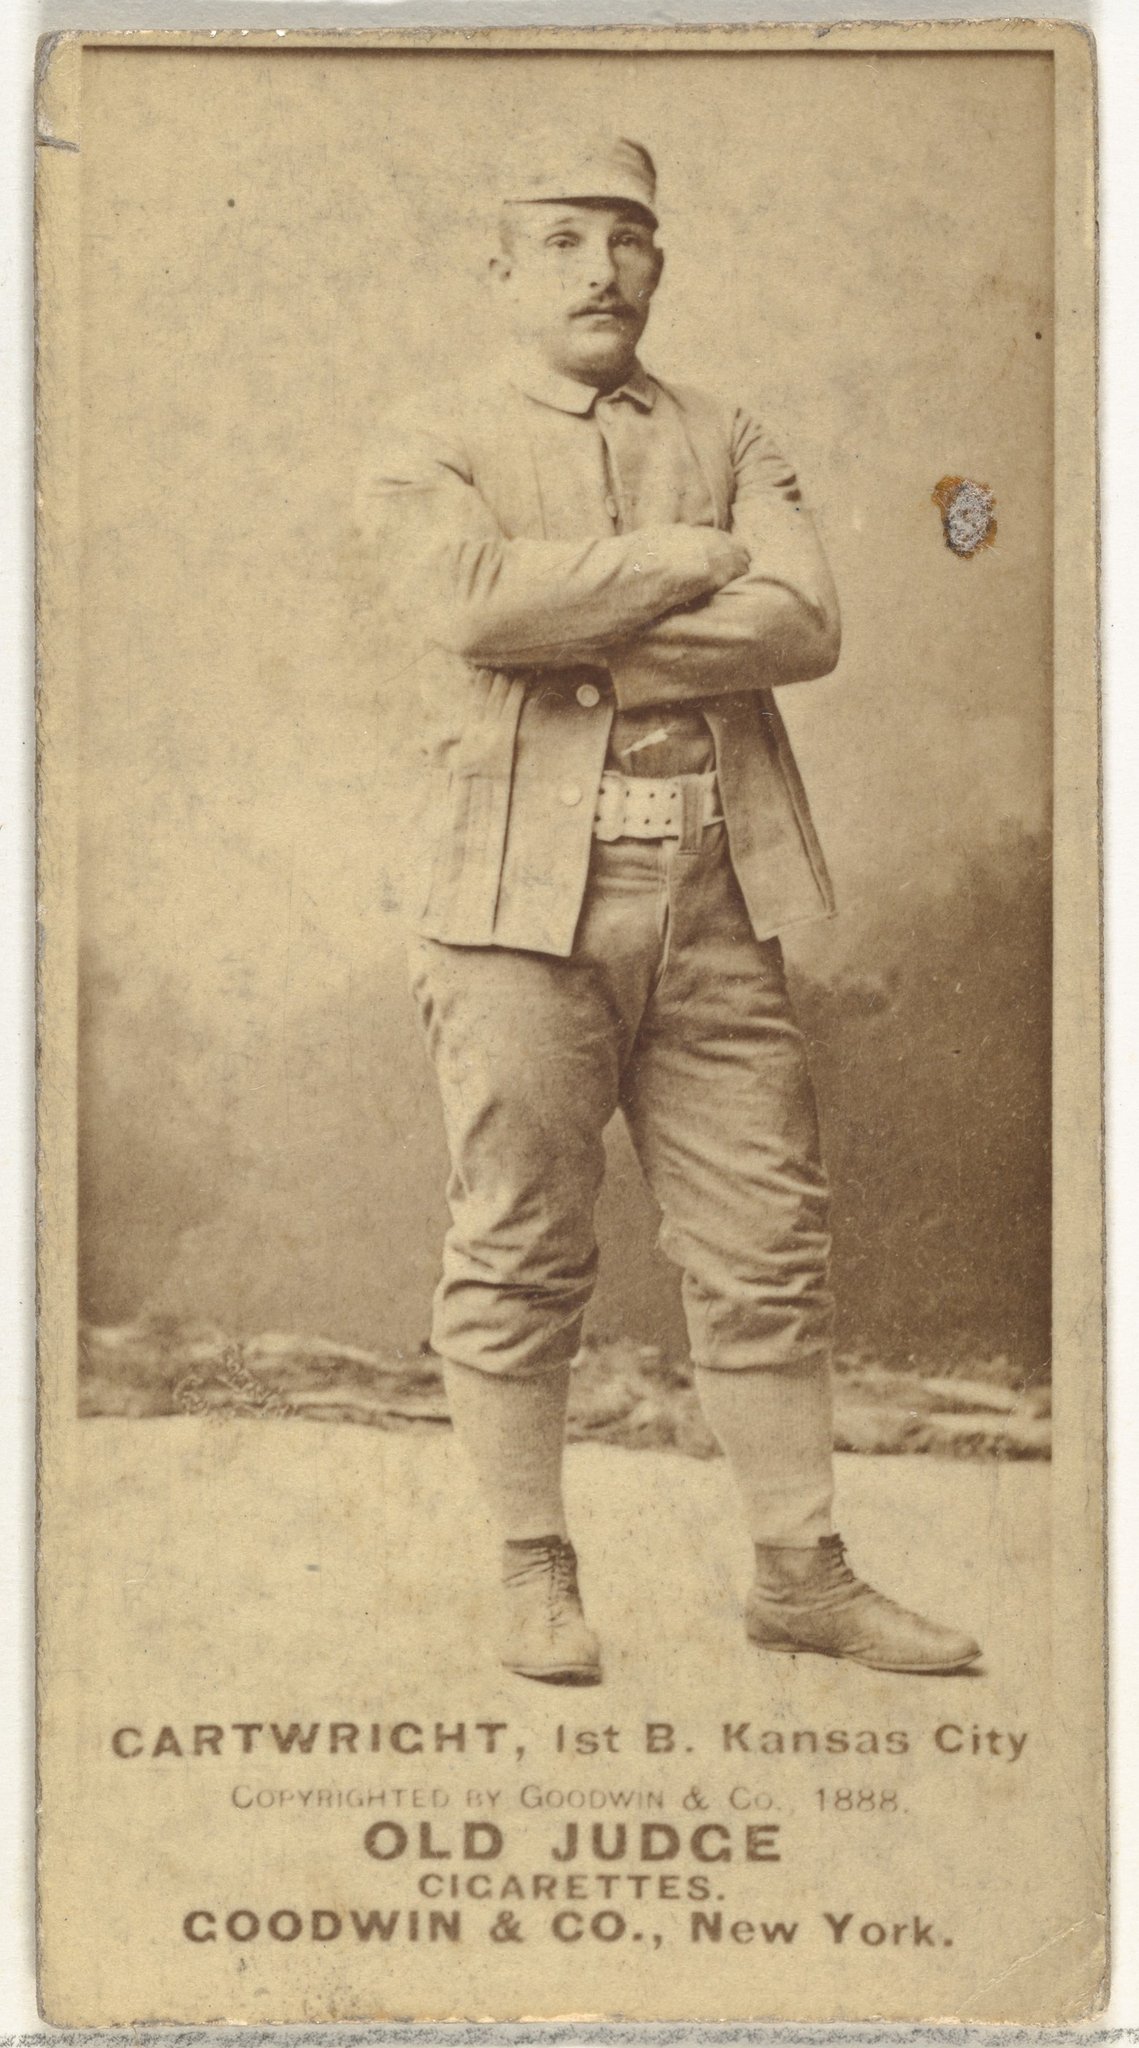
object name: baseball card, photograph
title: Cartwright, 1st Base, Kansas City Cowboys, from the Old Judge series (N172) for Old Judge Cigarettes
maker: goodwin & company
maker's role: publisher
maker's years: 1850-1950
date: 1888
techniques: albumen silver print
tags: men,portraits,baseball,athletes